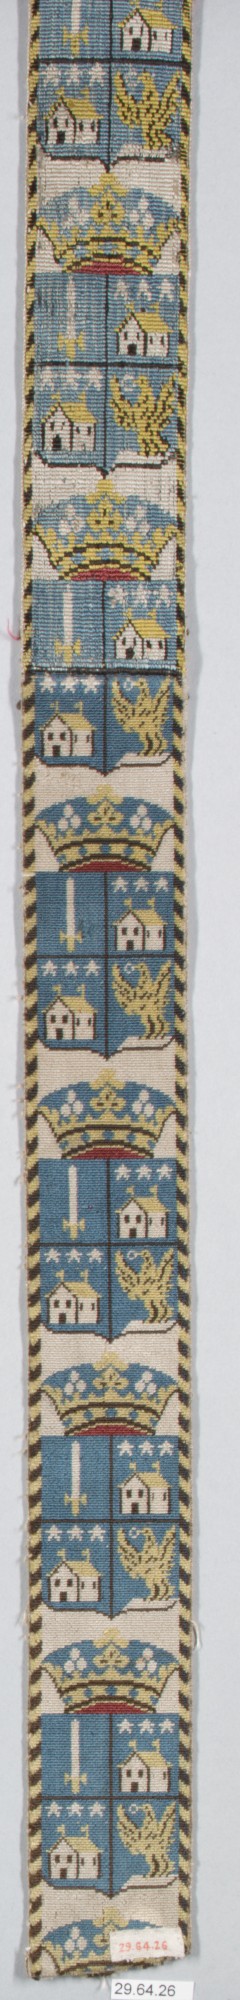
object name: galloon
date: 1701-1900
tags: houses,insignia